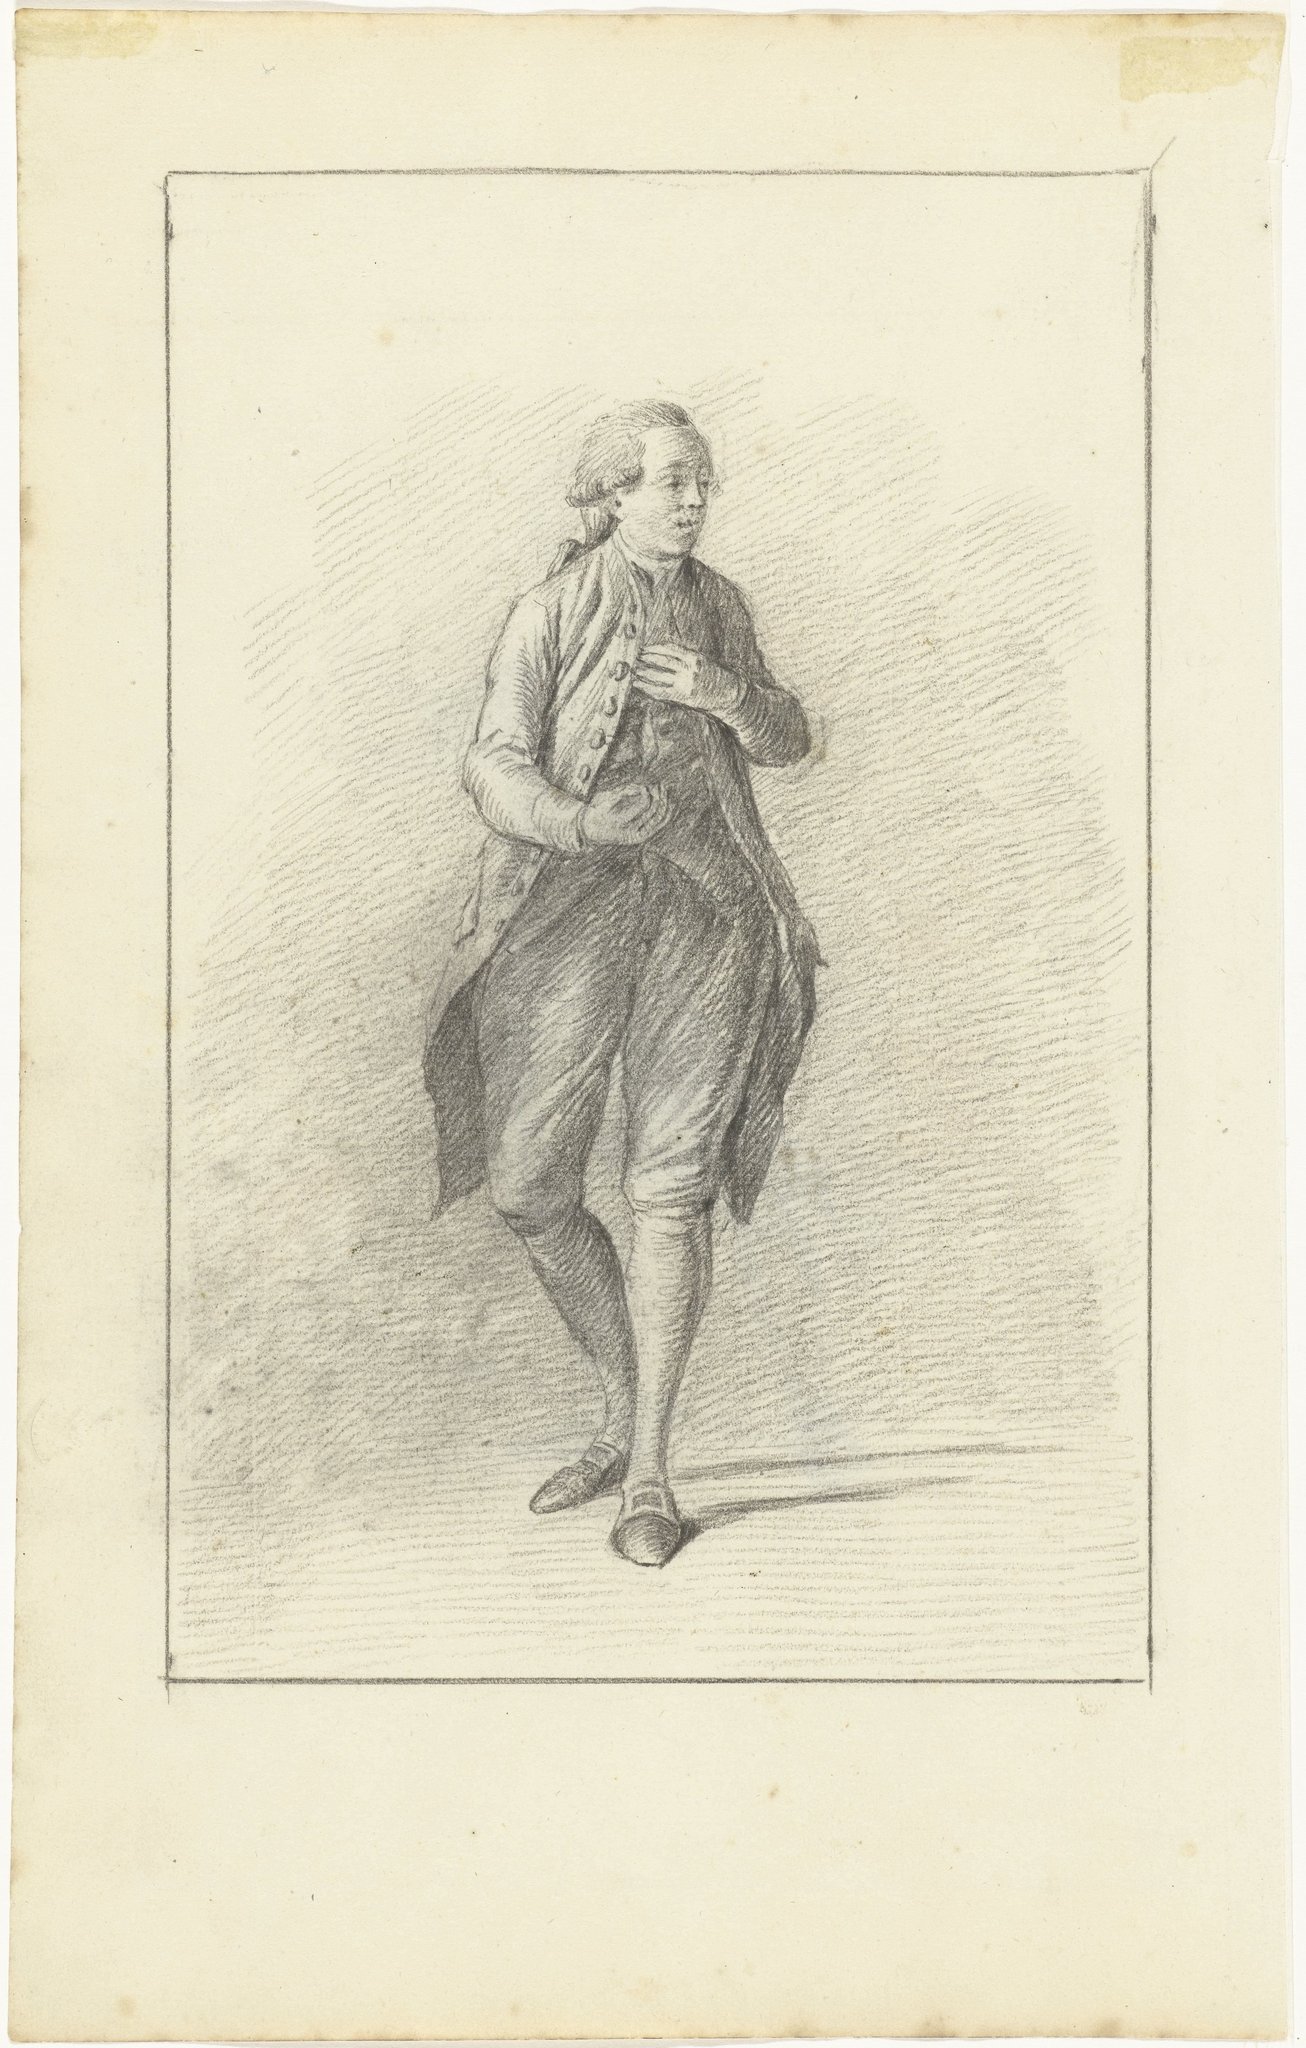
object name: drawing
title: Staande man, frontaal gezien, kijkend naar rechts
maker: nicolaes muys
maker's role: draughtsman, painter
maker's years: 1740-1808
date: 1750-1808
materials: chalk, paper